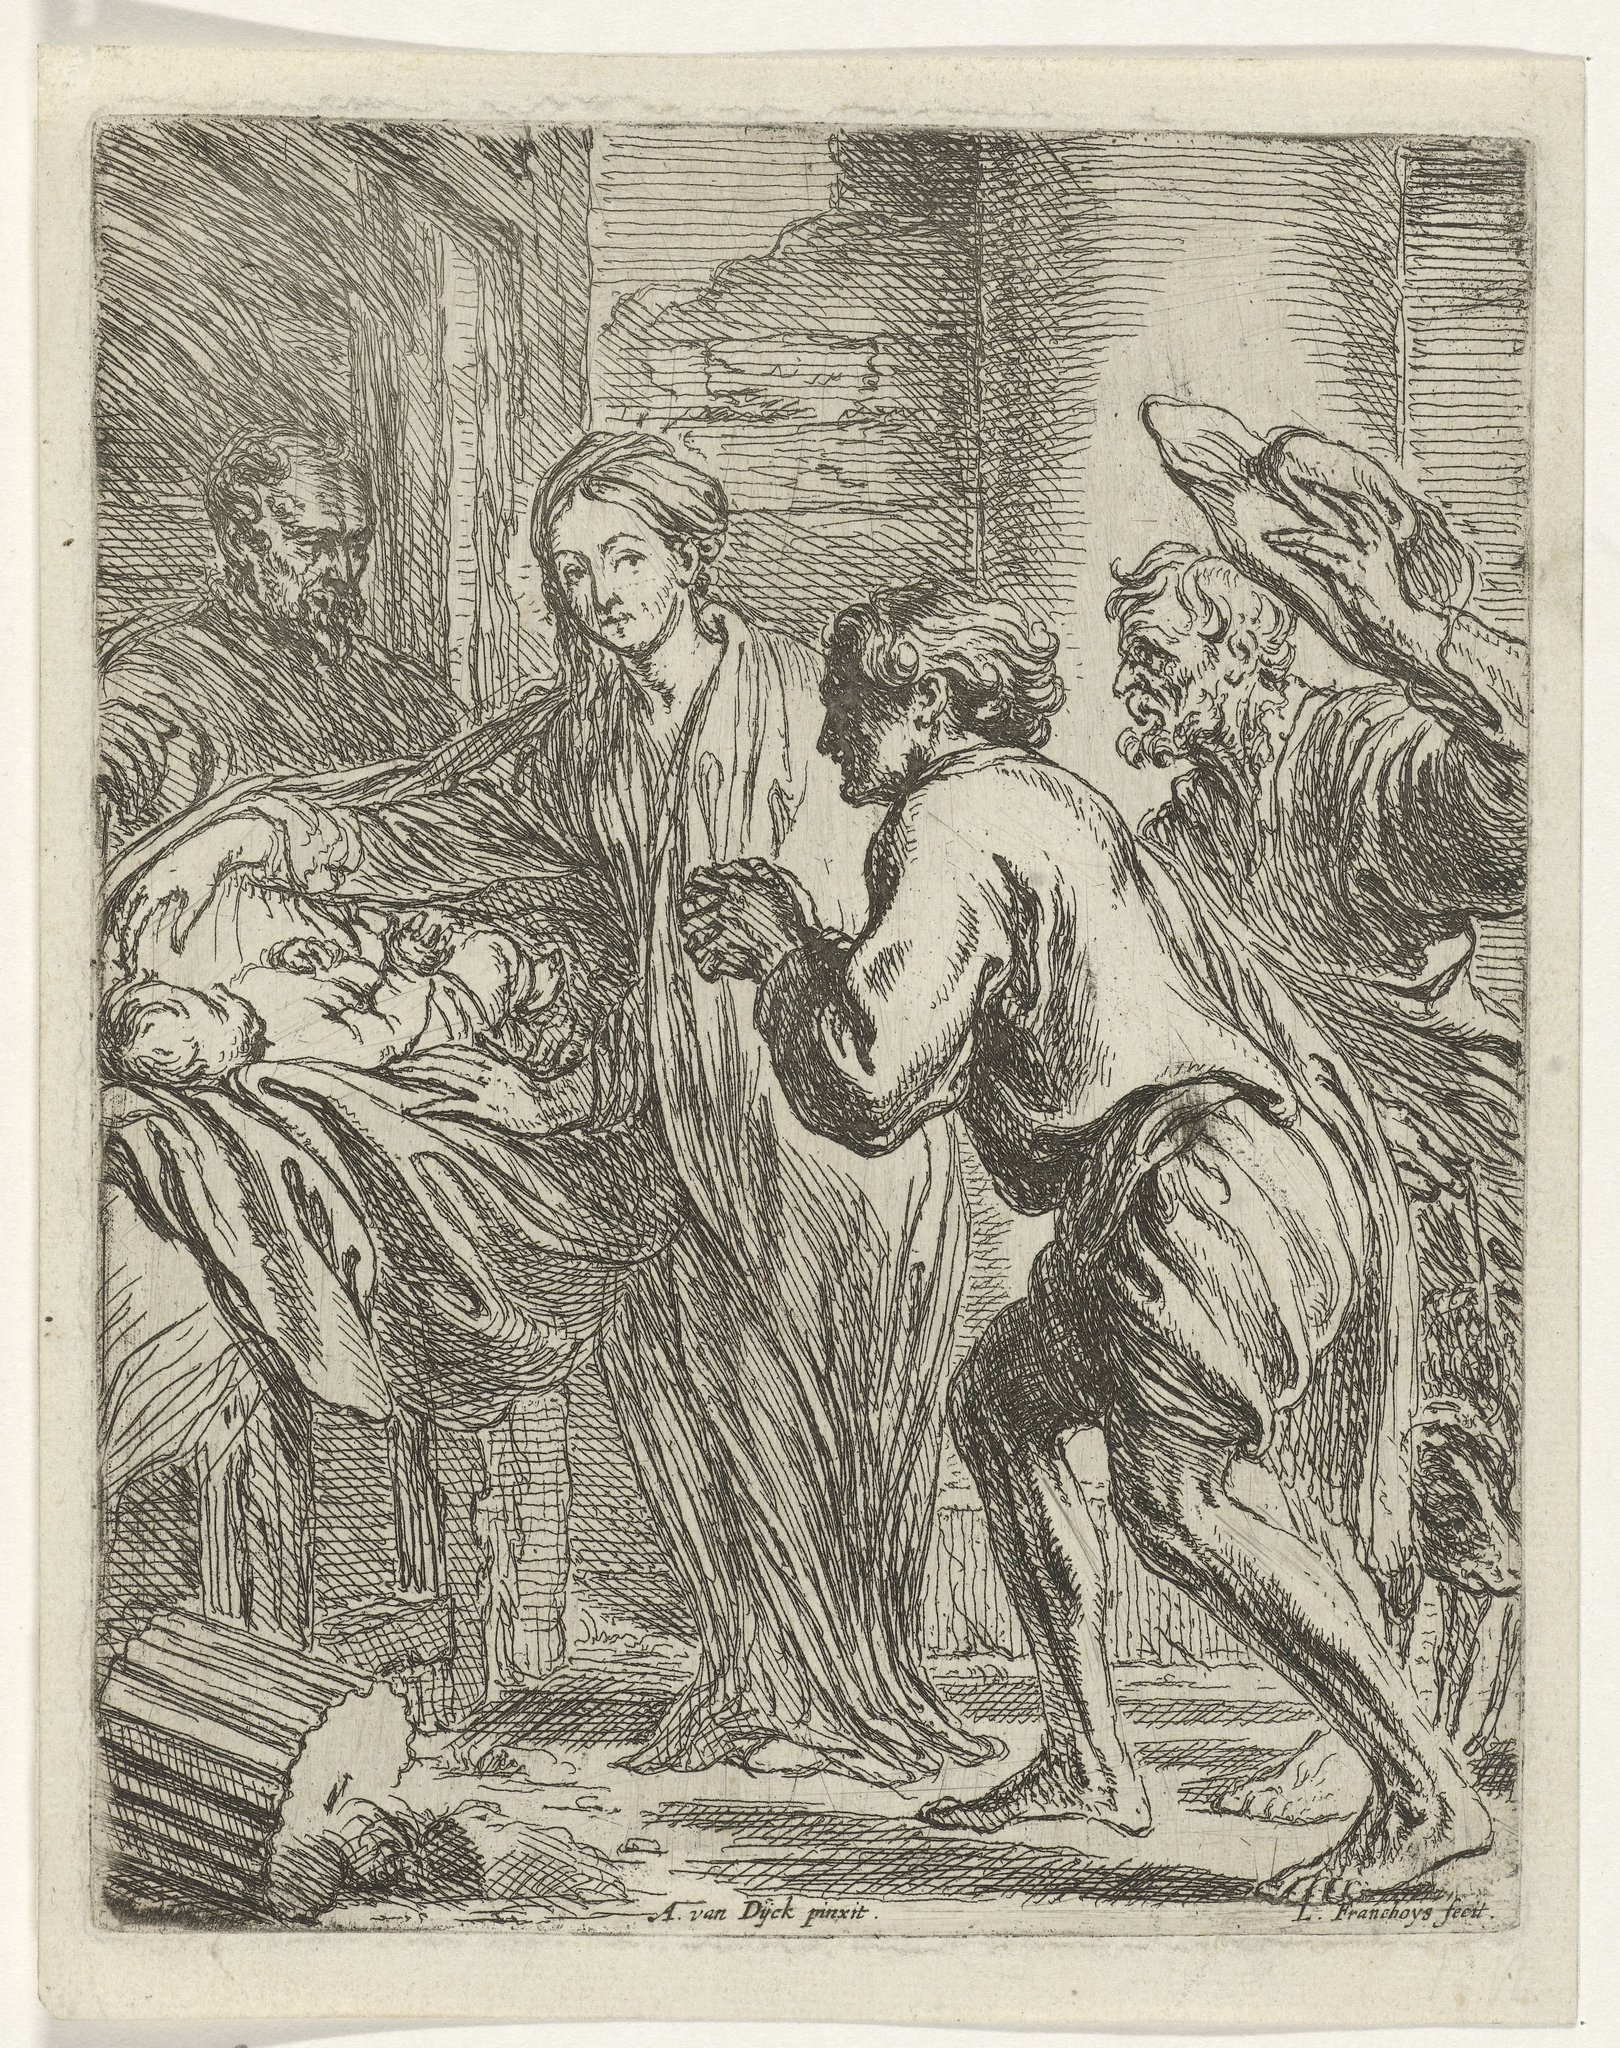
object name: print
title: De aanbidding door de herders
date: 1626-1681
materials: paper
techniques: etching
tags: adoration of the christ-child by the shepherds; mary and joseph present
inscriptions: collector's mark: Lugt 2165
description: Twee herders bezoeken de Heilige Familie en staan in aanbidding voor het Christuskind.